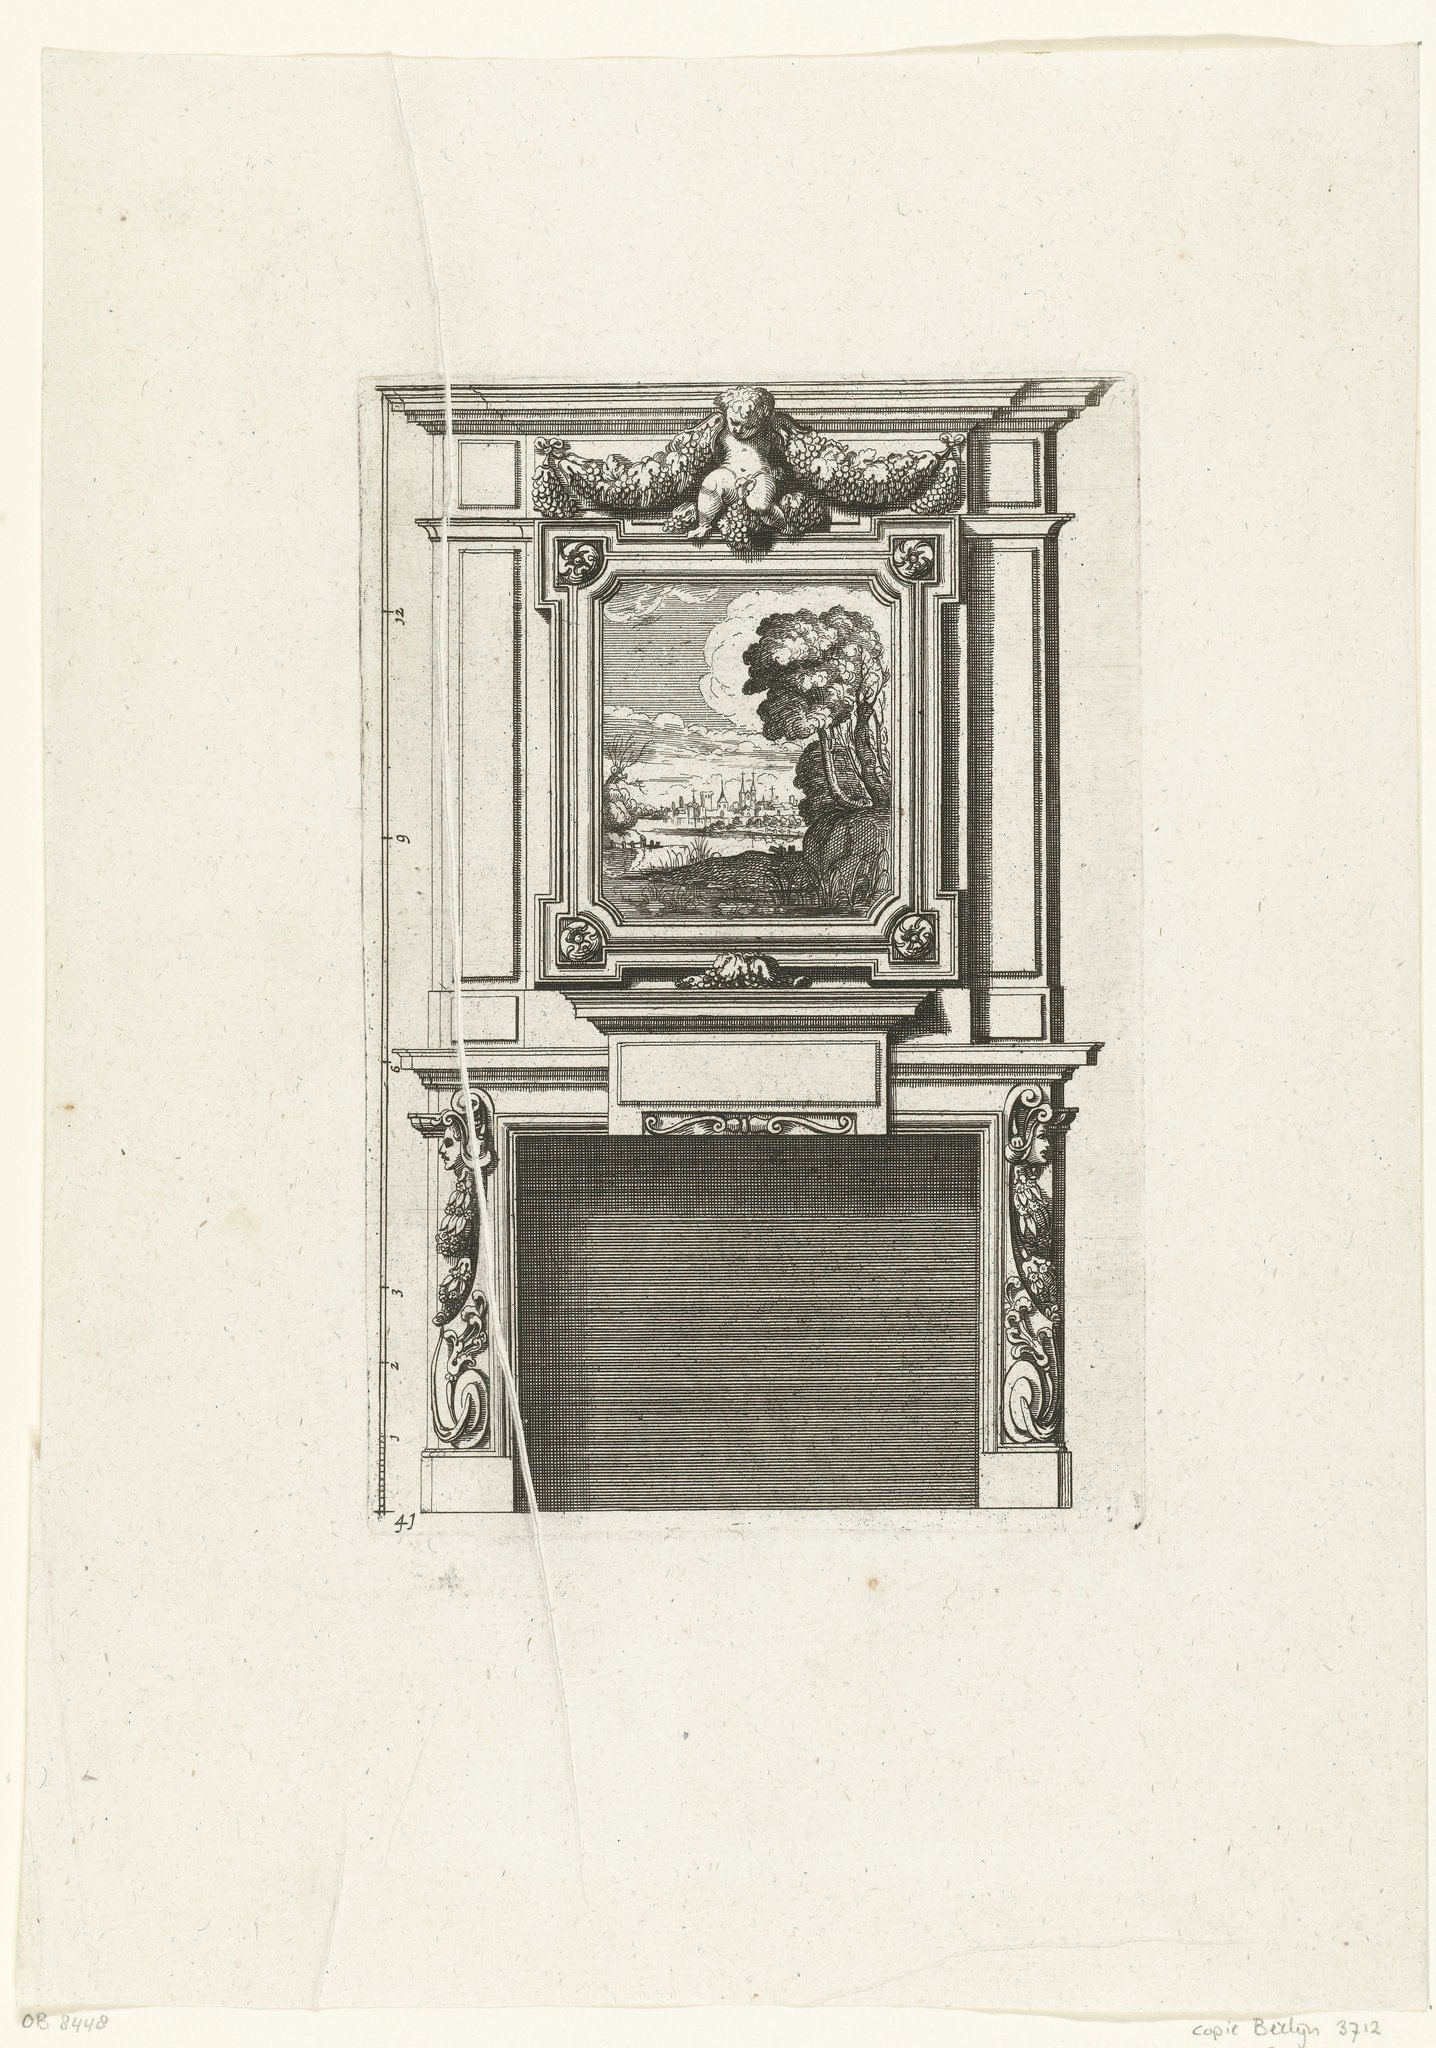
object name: print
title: Onderboezems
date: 1642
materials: paper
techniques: etching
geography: amsterdam